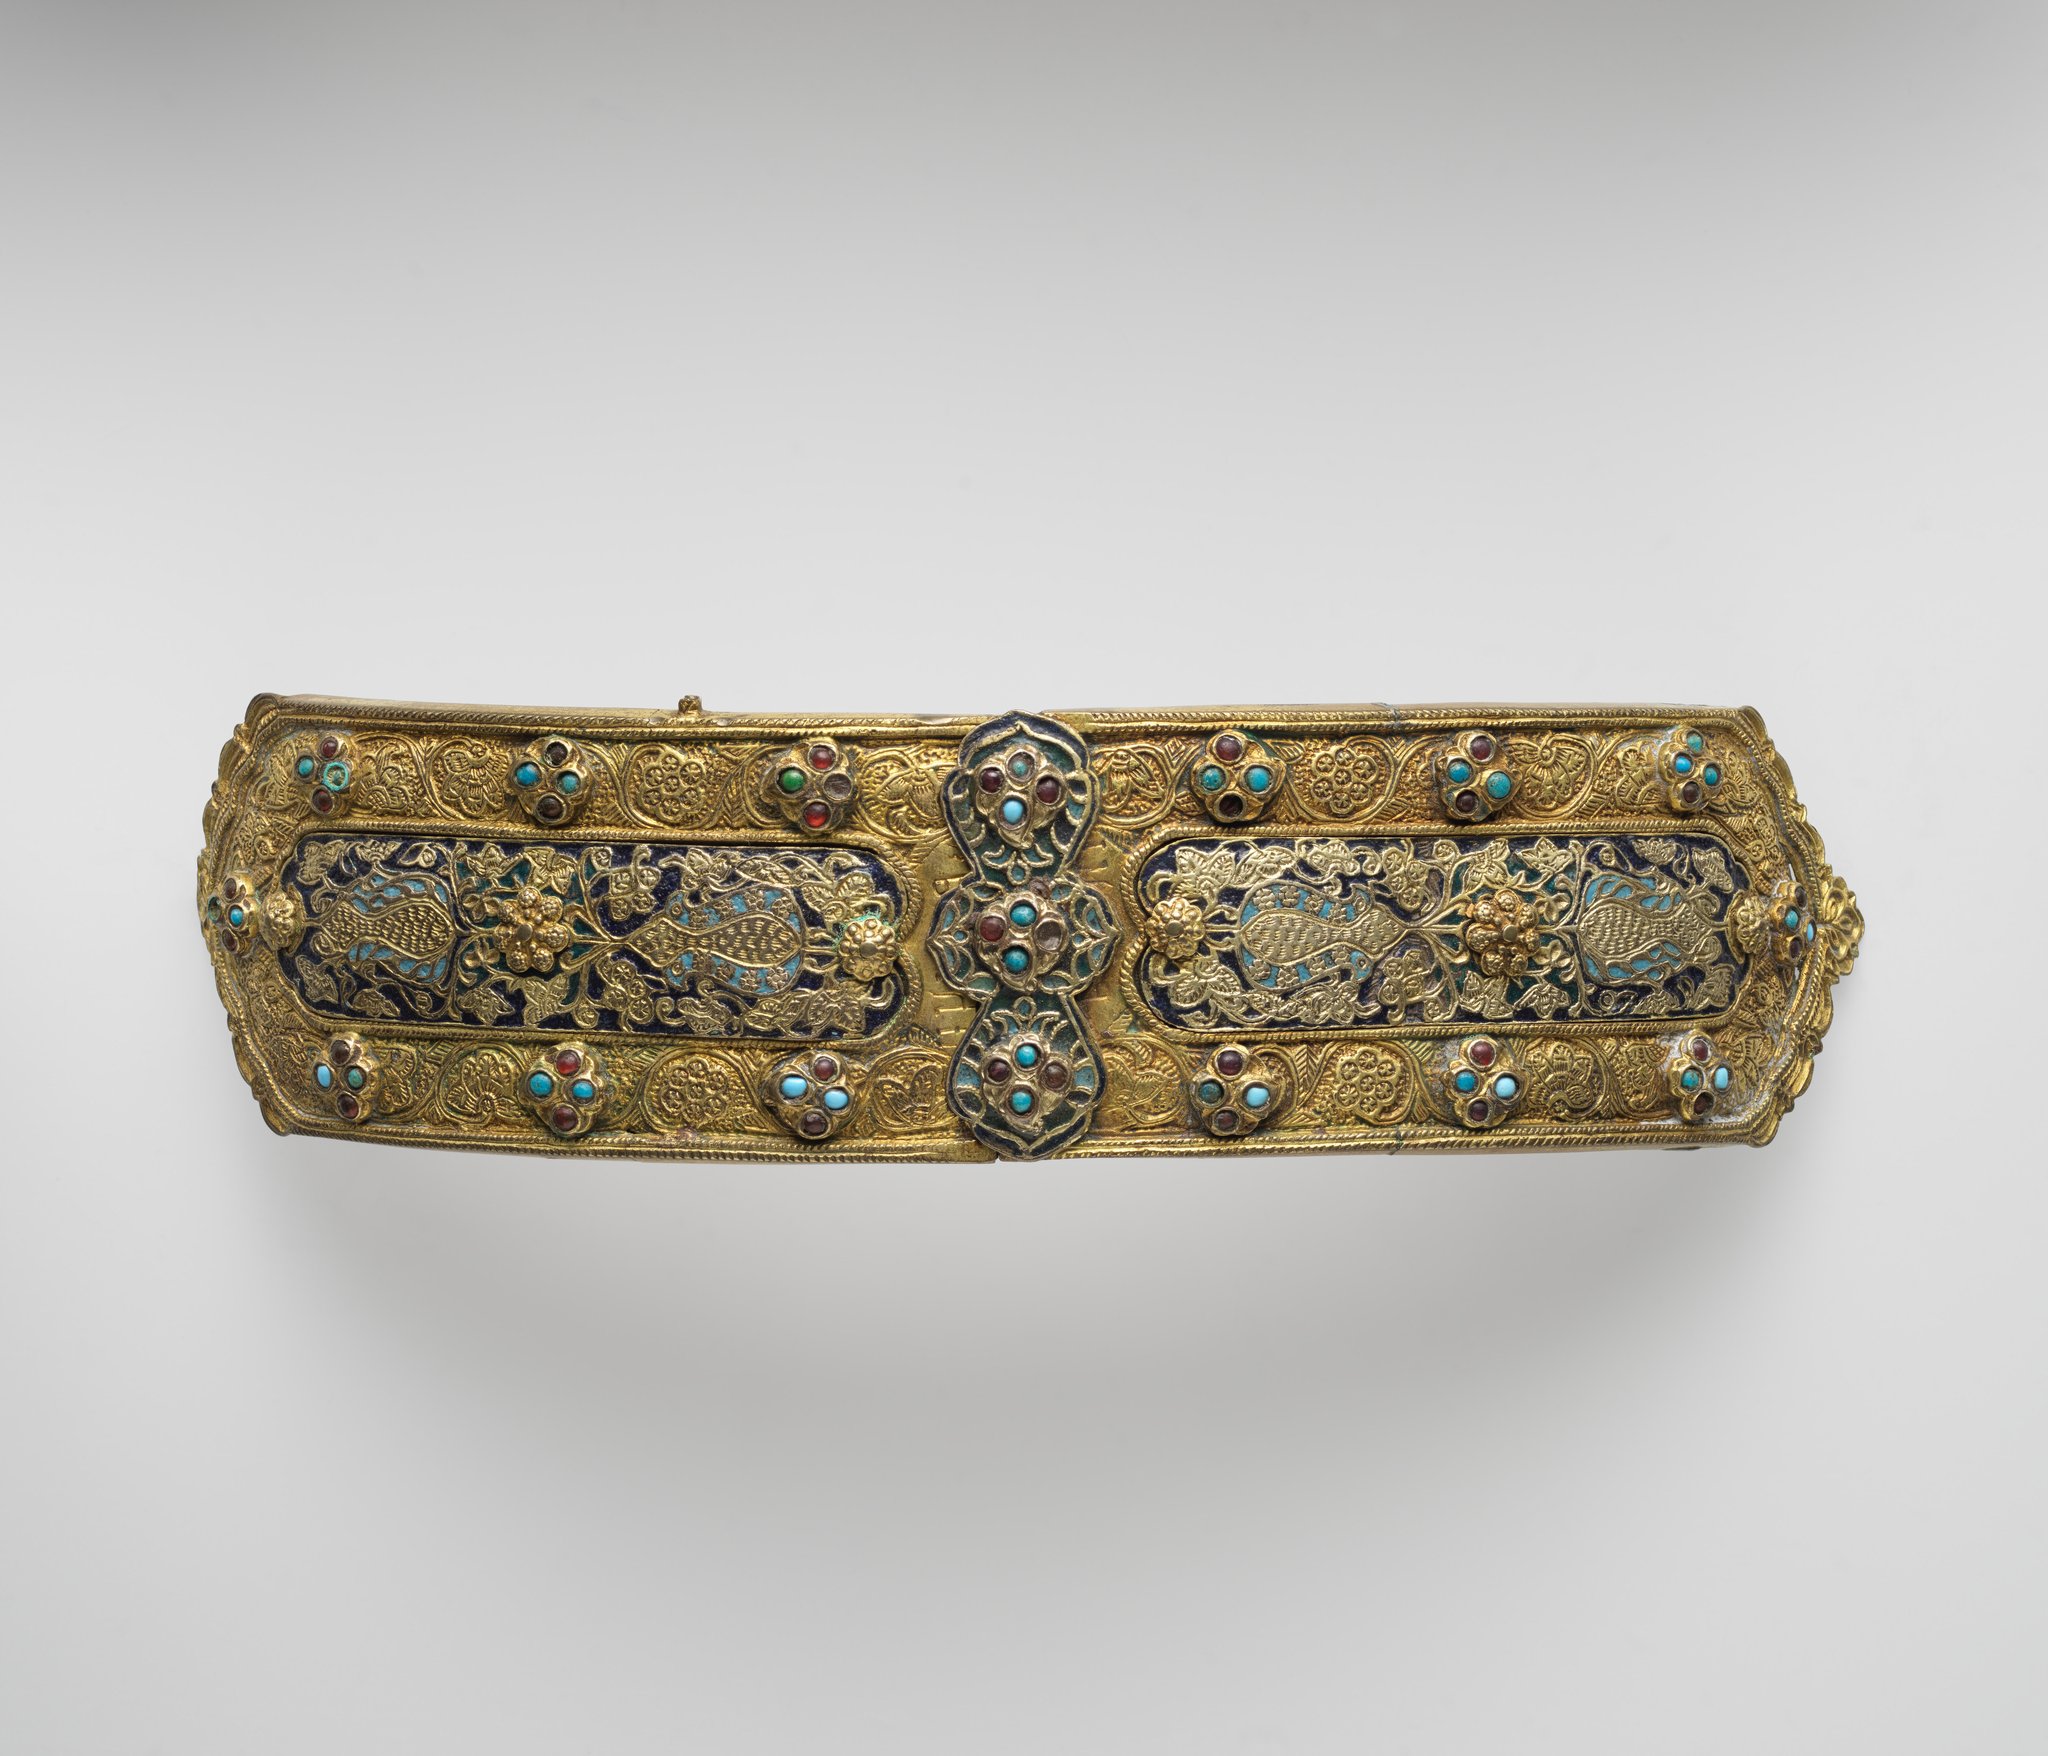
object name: girdle clasp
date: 1801-1900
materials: brass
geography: caucasus or turkey